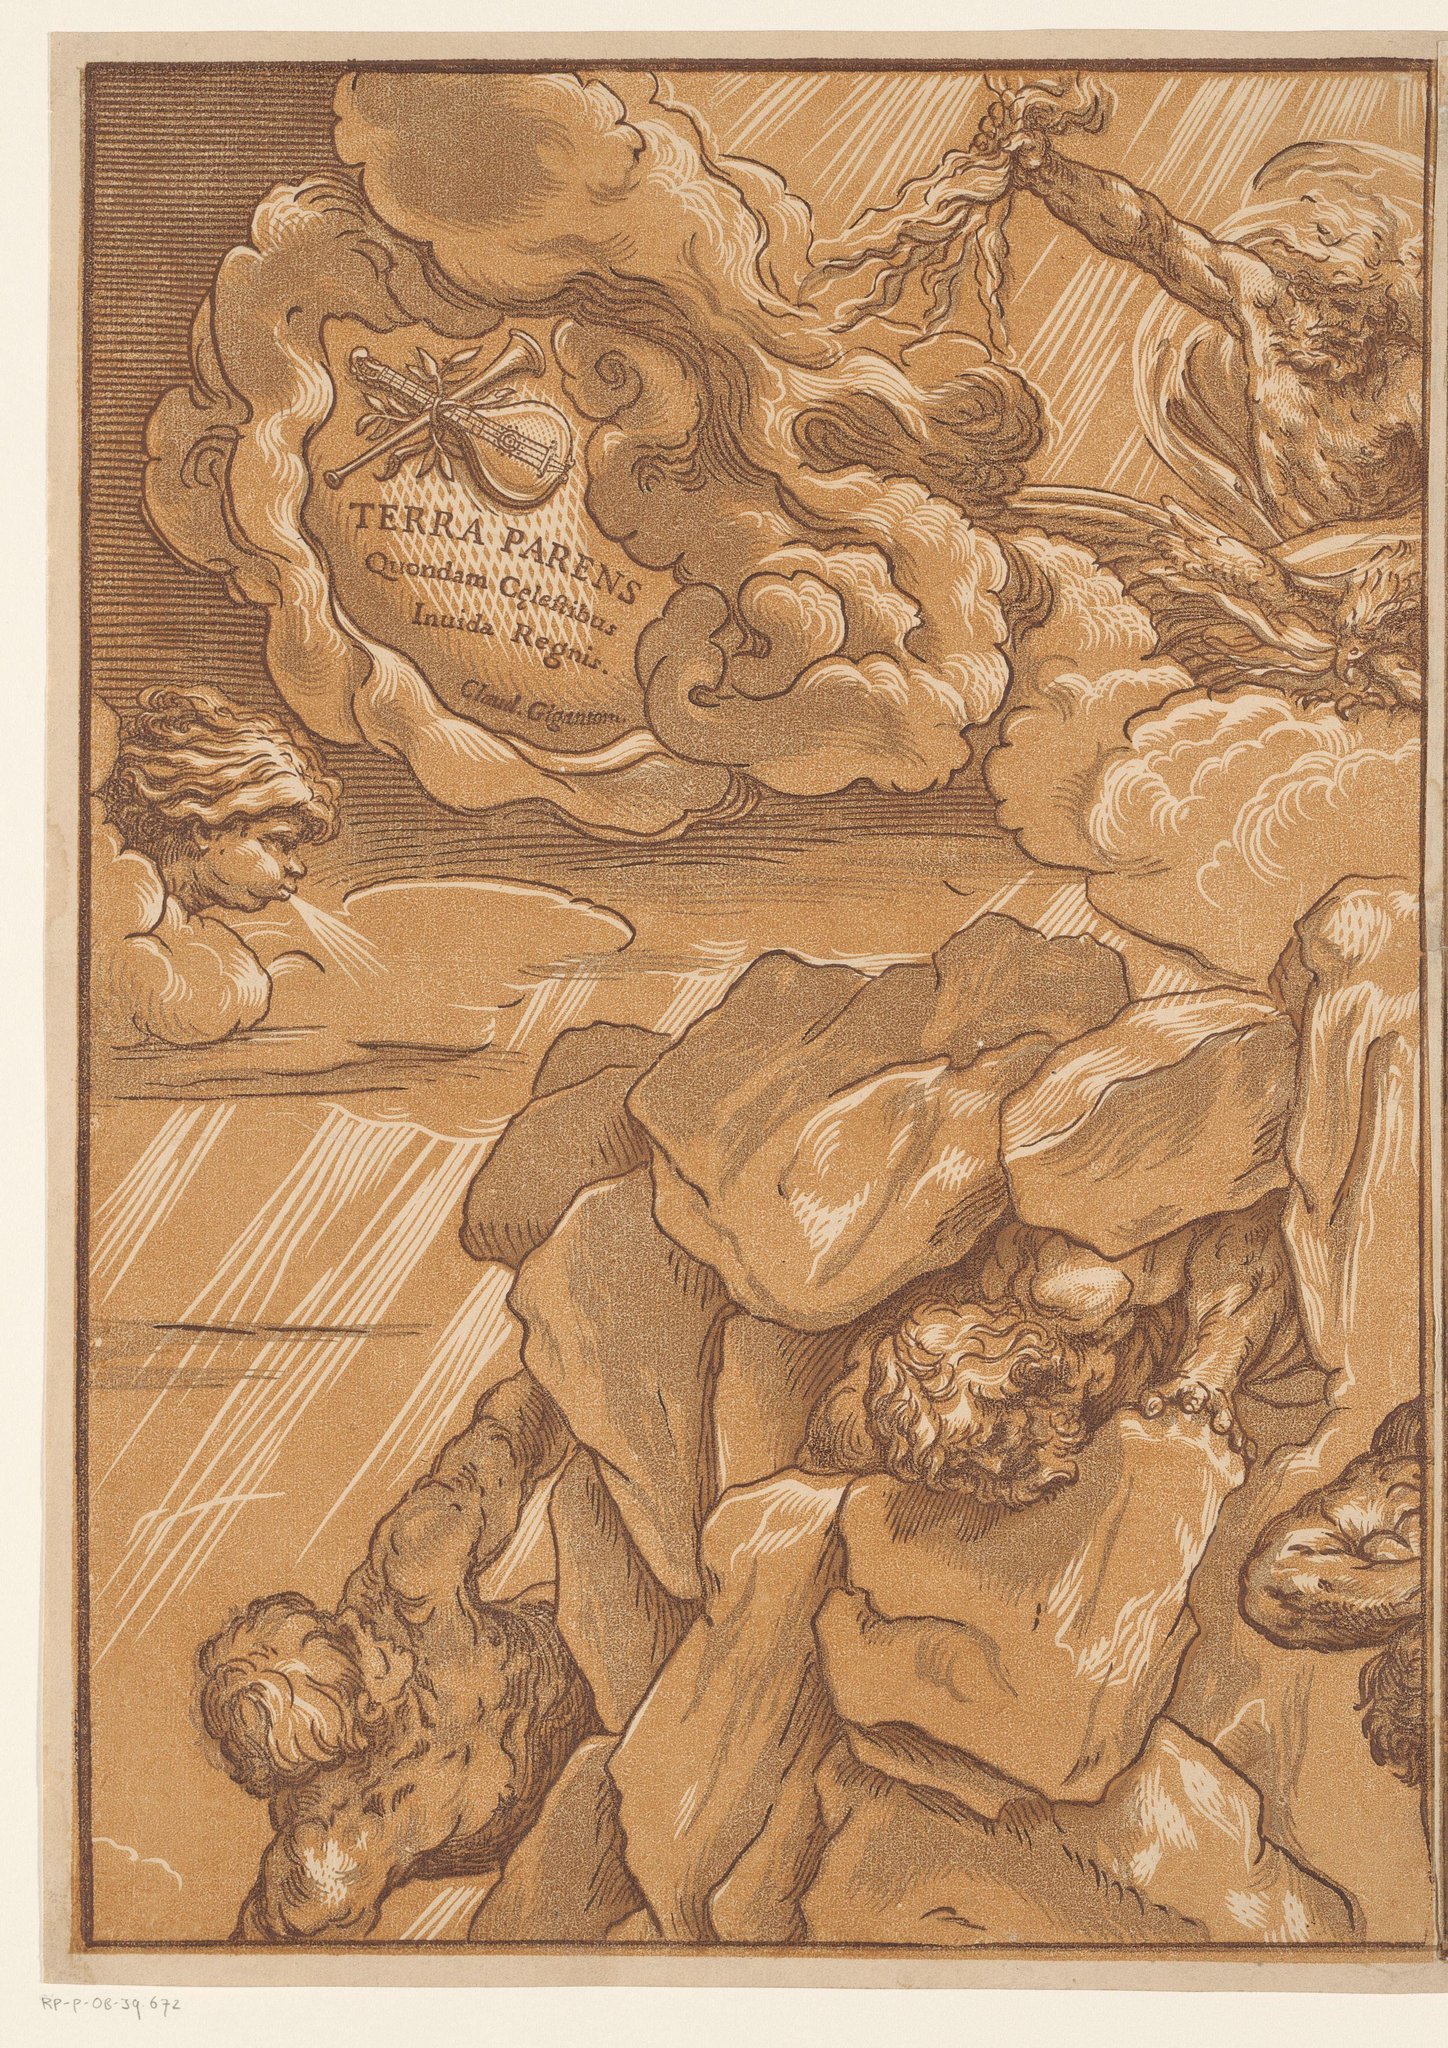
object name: print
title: Val van de giganten (tweede deel)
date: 1647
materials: paper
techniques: woodcut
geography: bologna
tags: battle of the giants against the gods: gigantomachy, the giants buried beneath volcanoes, gods of the winds, giants, colossi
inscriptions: date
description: De giganten die de hemel bestormden om Jupiter ten val te brengen, worden onder stenen bedolven. Bovenaan de woedende Jupiter met adelaar en bliksemschichten. Links en rechts blazende windgoden.